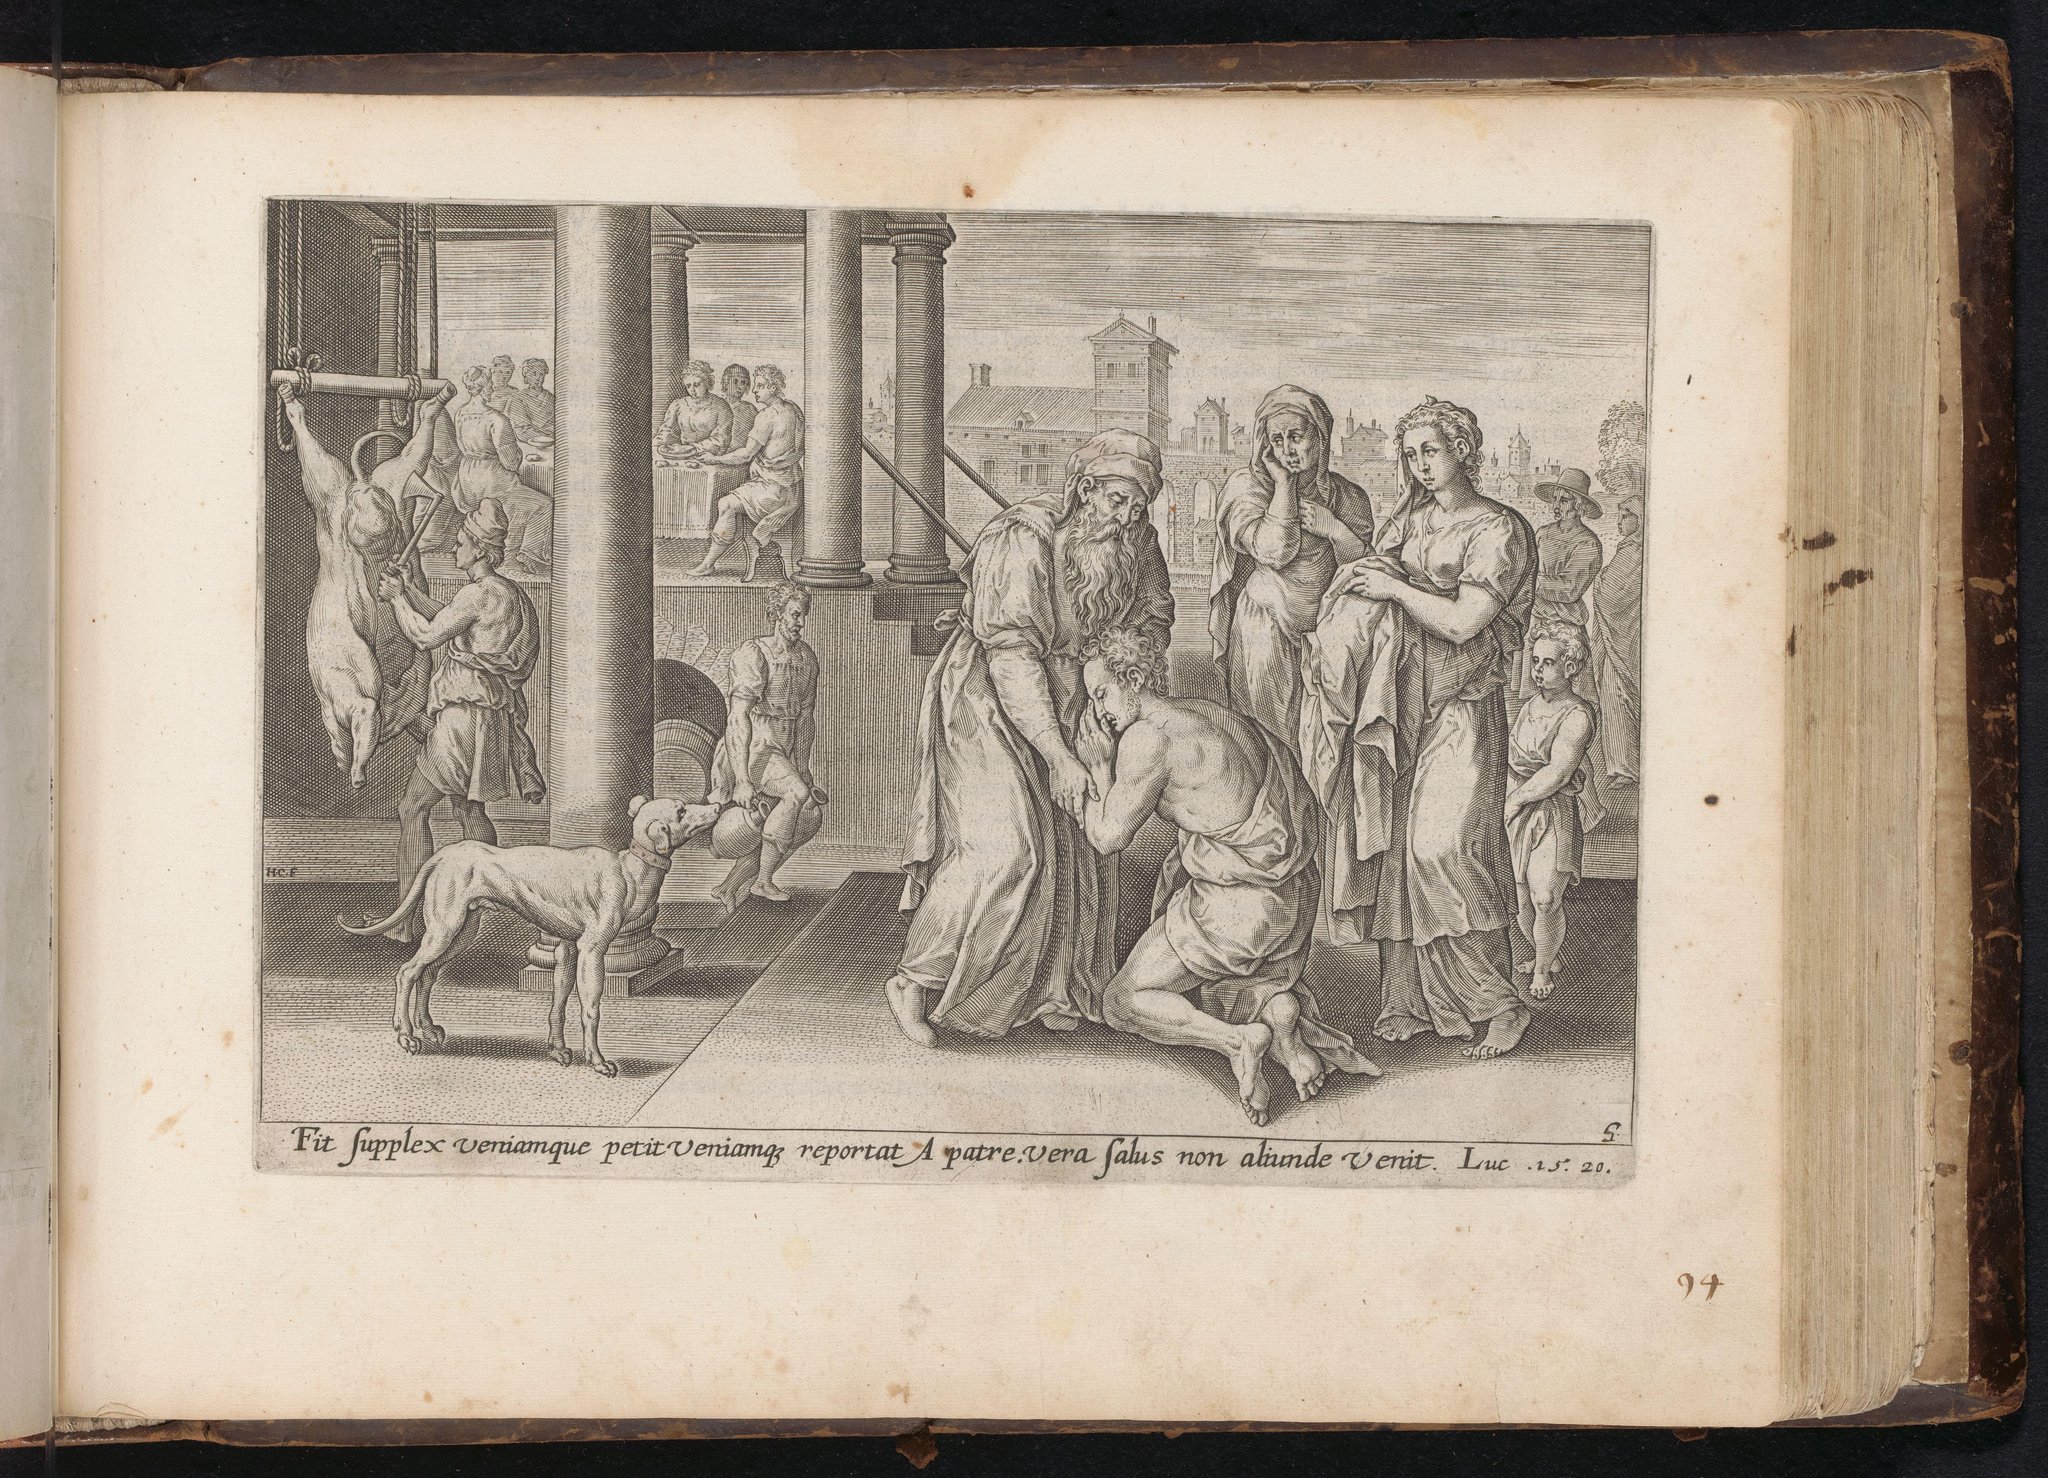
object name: print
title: Terugkeer van de verloren zoon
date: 1585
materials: paper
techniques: engraving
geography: amsterdam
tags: the prodigal son kneels before his father who takes him in his arms, preparations, e.g. the prodigal son is given new robes; slaughtering of the fatted calf; the elder son objects, festive reception of the prodigal son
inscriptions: serial number: ‘5’, number: ‘94’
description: De verloren zoon keert terug naar huis en valt zijn vader in de armen. Links wordt het gemeste kalf geslacht en links op de achtergrond wordt een feestmaal gegeven om de terugkeer van de verloren zoon te vieren. Onder de voorstelling een verwijzing in het Latijn naar de Bijbeltekst in Luc. 15:20. Deze prent maakt deel uit van een album.